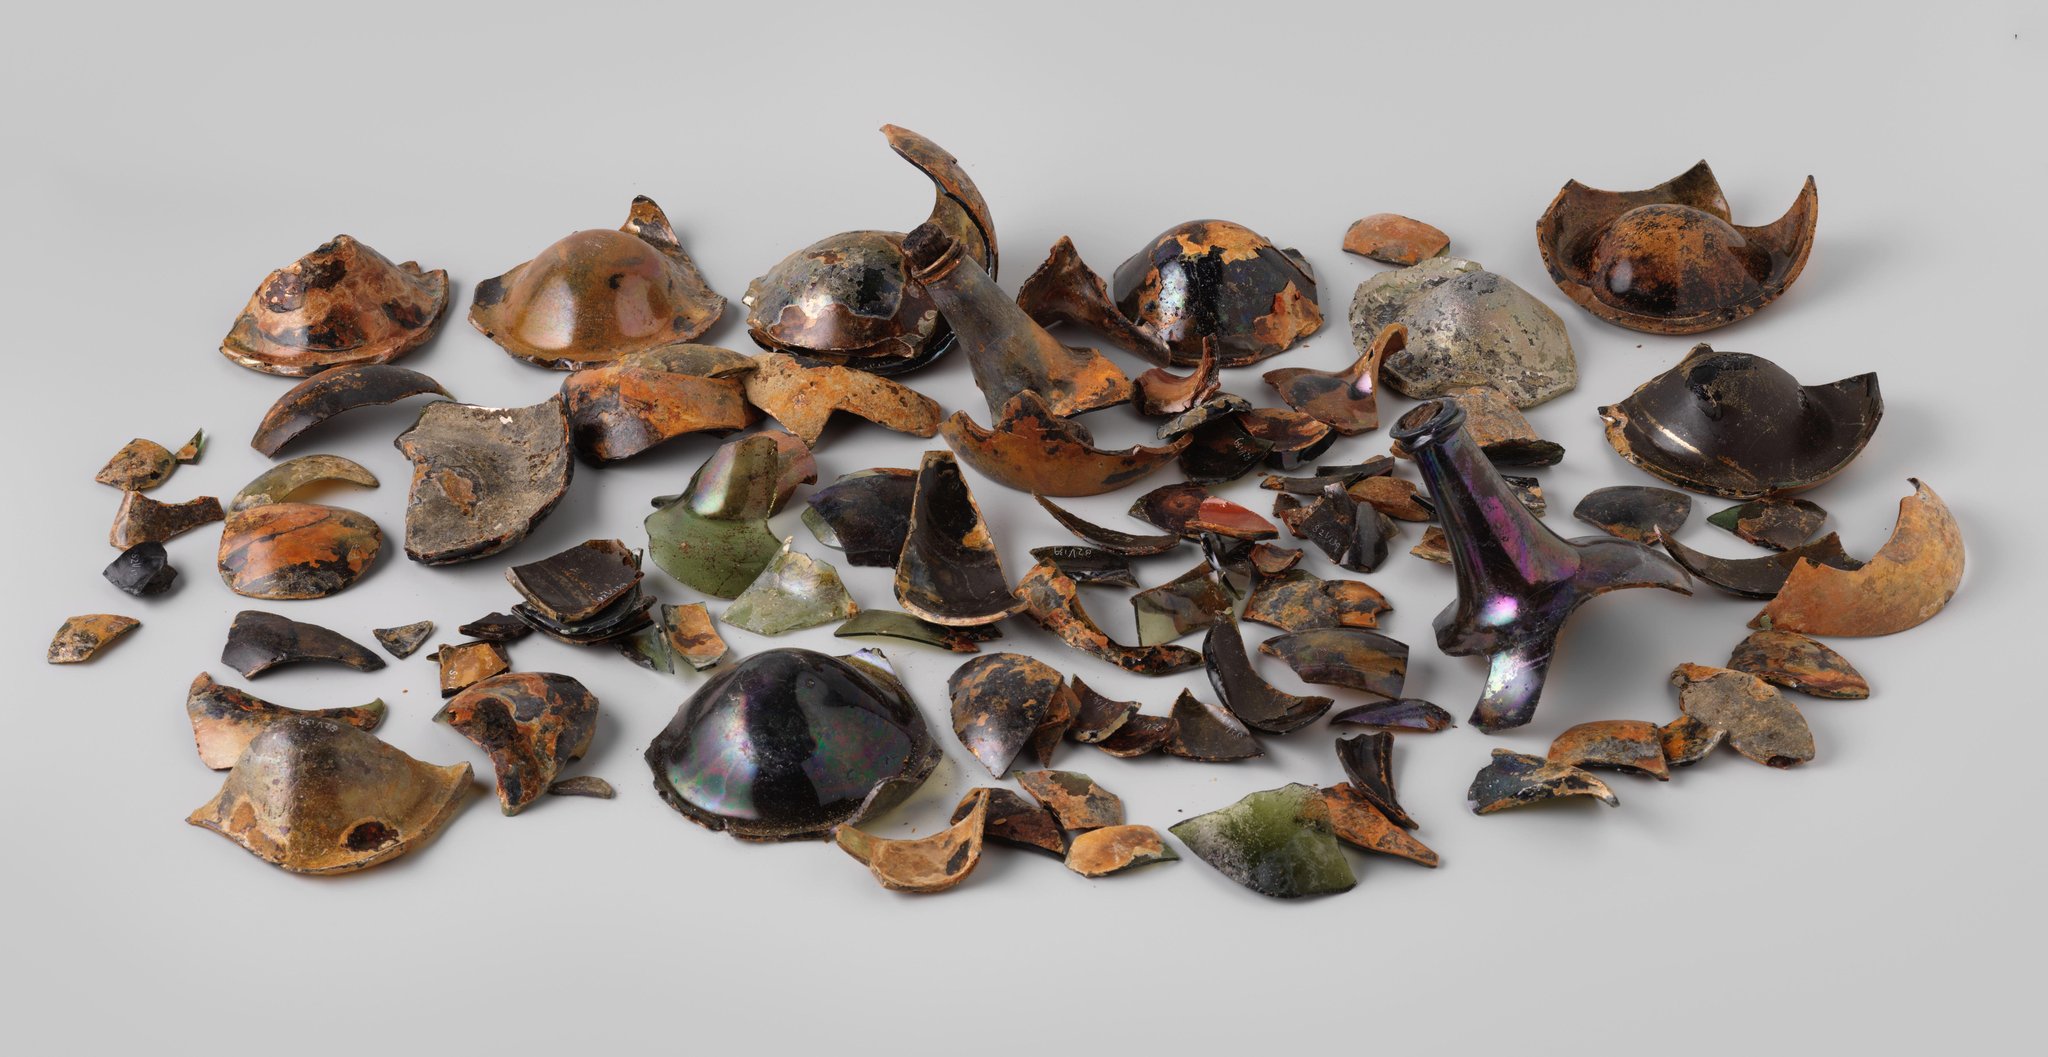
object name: wine bottle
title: Scherven van wijnflessen uit het wrak van de Oost-Indiëvaarder 't Vliegend Hart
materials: cork, glass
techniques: green glass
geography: netherlands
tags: 't vliegend hart (schip), verenigde oostindische compagnie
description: Scherven van uivormige wijnflessen van groen glas waar rode (port)wijn in heeft gezeten. Enkele halzen nog met kurk.